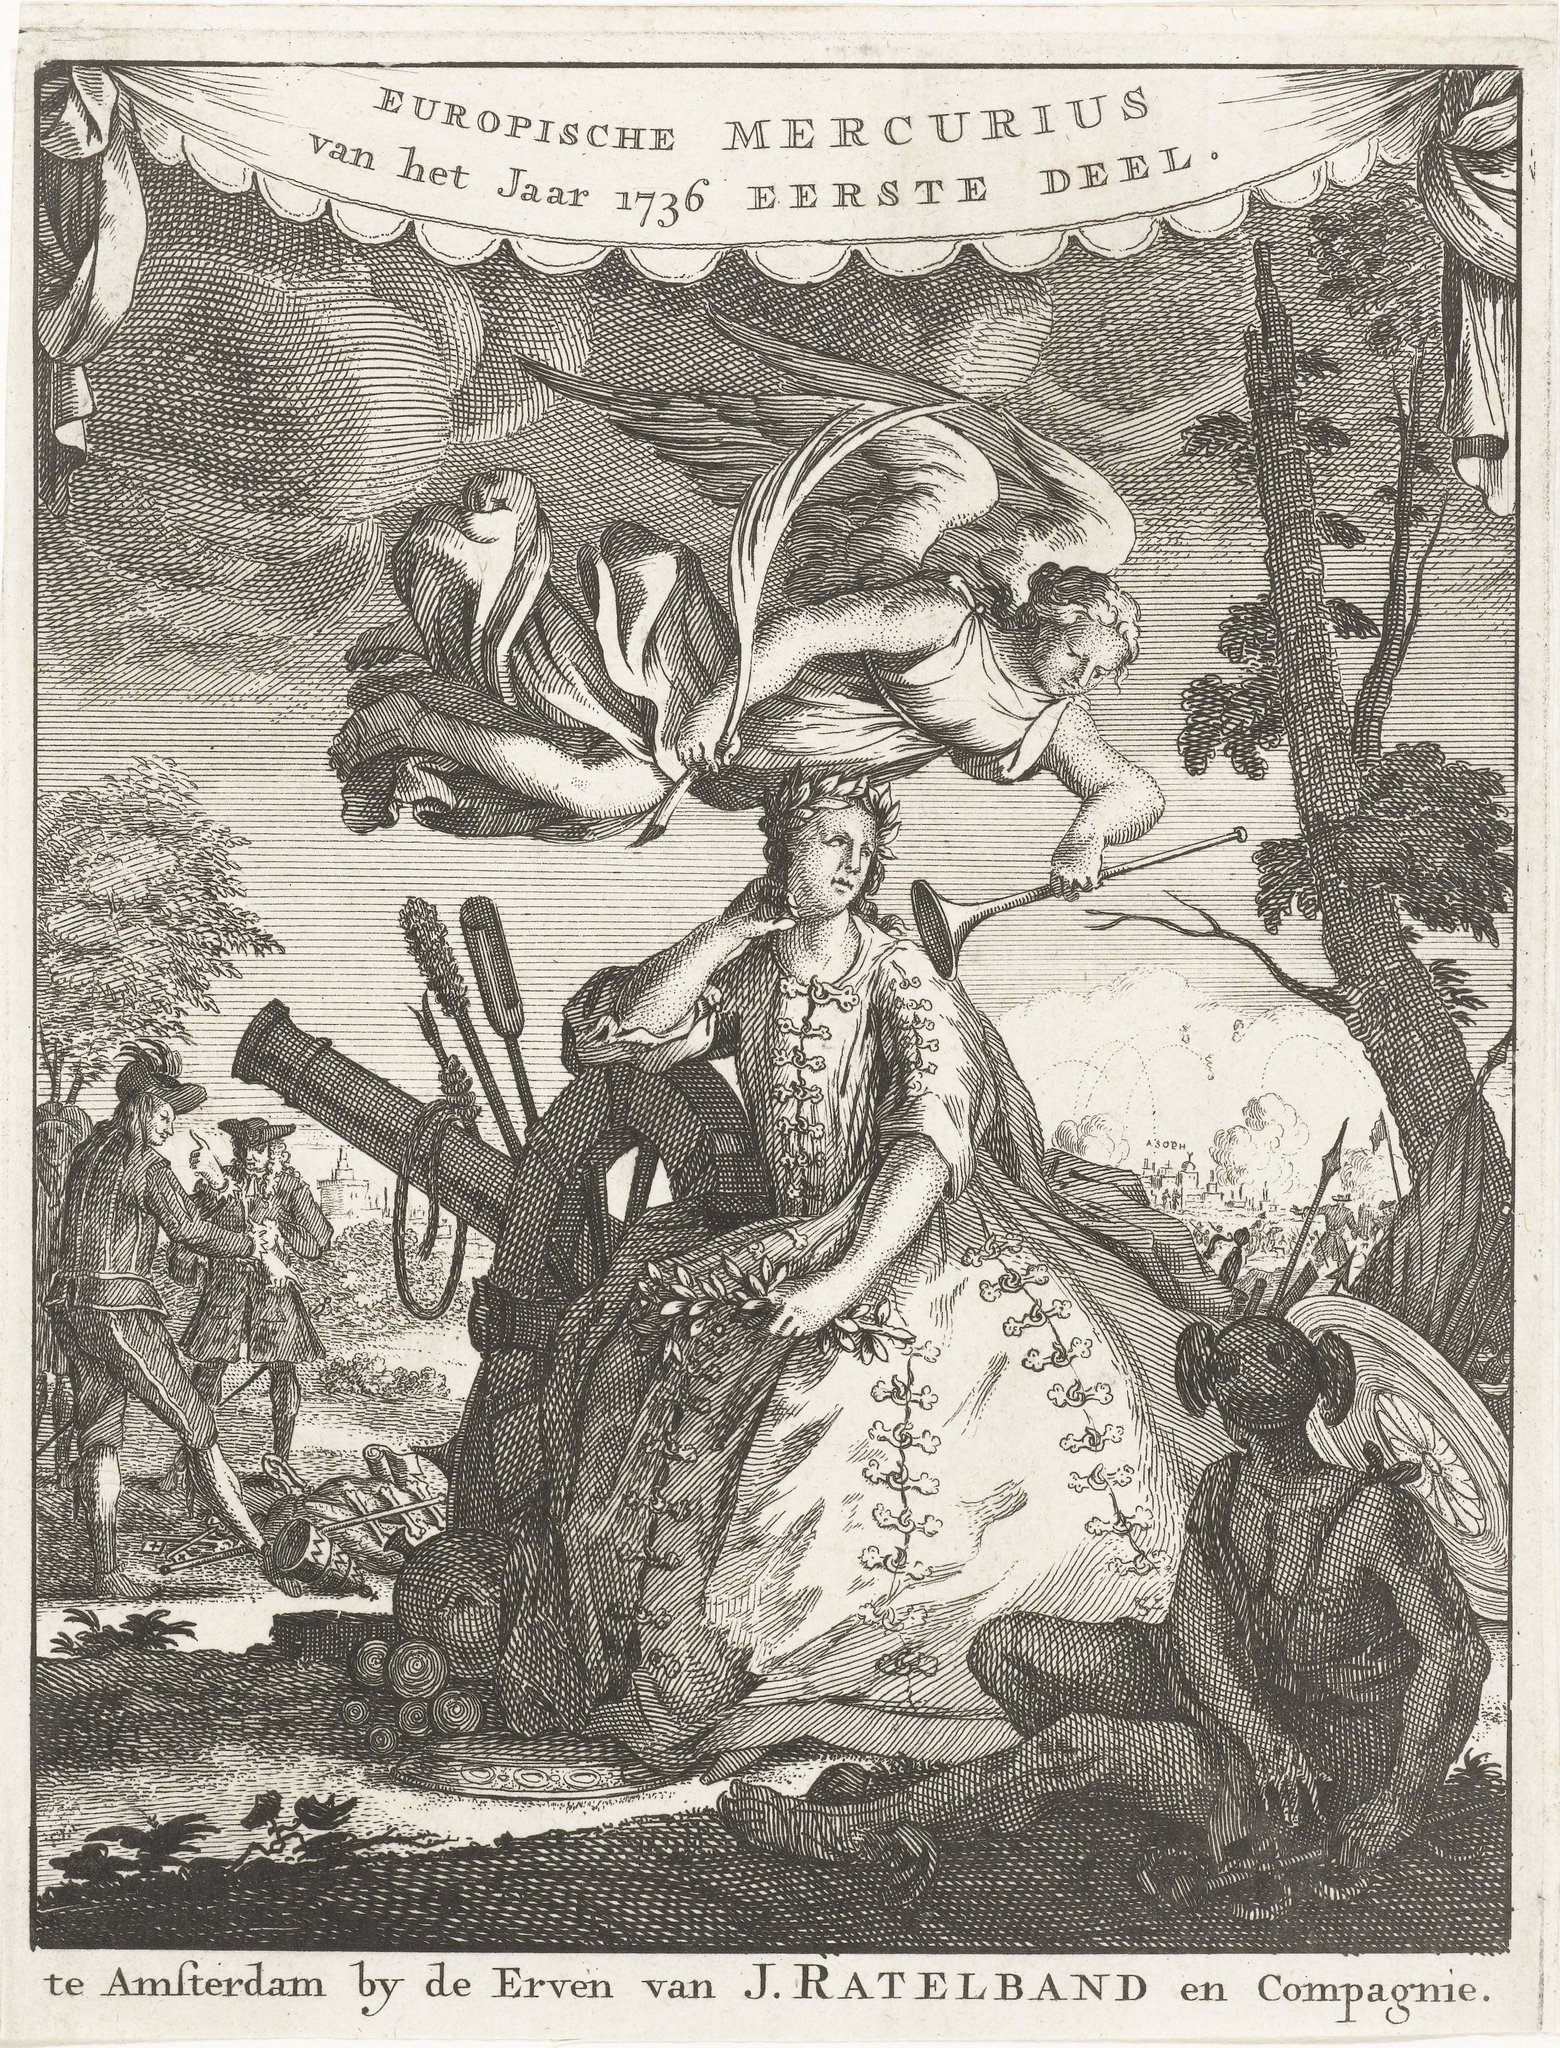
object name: print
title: Titelpagina voor de Europische Mercurius van 1736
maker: johannes de ruijter (1688-1744)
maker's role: print maker, publisher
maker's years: 1688-1744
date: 1736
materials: paper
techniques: engraving, etching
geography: amsterdam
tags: symbols, allegories of peace, 'pax'; 'pace' (ripa)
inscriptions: collector's mark: Lugt 2228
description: Titelpagina voor de Europische Mercurius, over het jaar 1736. De Vrede zittend bij een kanon, in de lucht de Faam, op de achtergrond een oorlogstafereel.